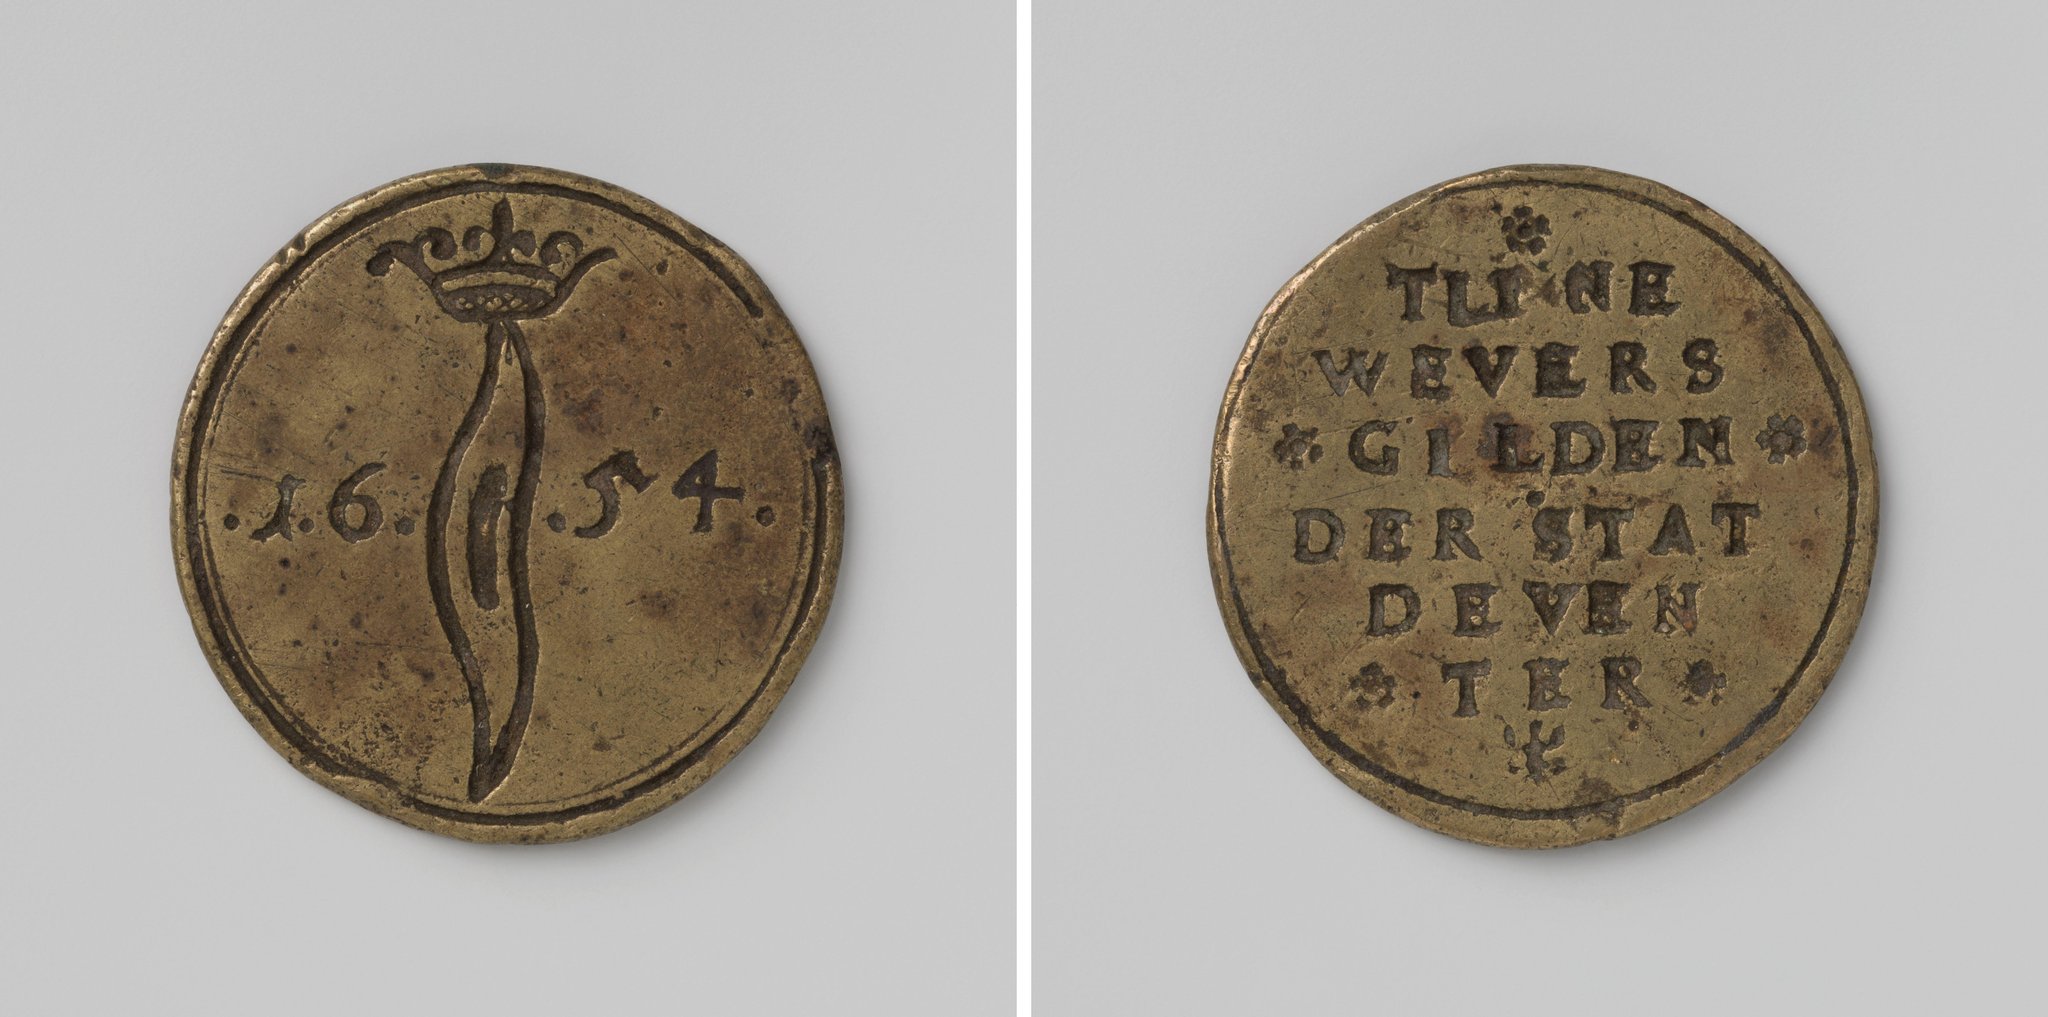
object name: medal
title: Linnenweversgilde van Deventer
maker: Anonymous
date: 1654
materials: brass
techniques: engraving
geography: deventer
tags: deventer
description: Messing penning. Voorzijde: staande weversspoel onder kroon. Keerzijde: opschrift boven adelaar